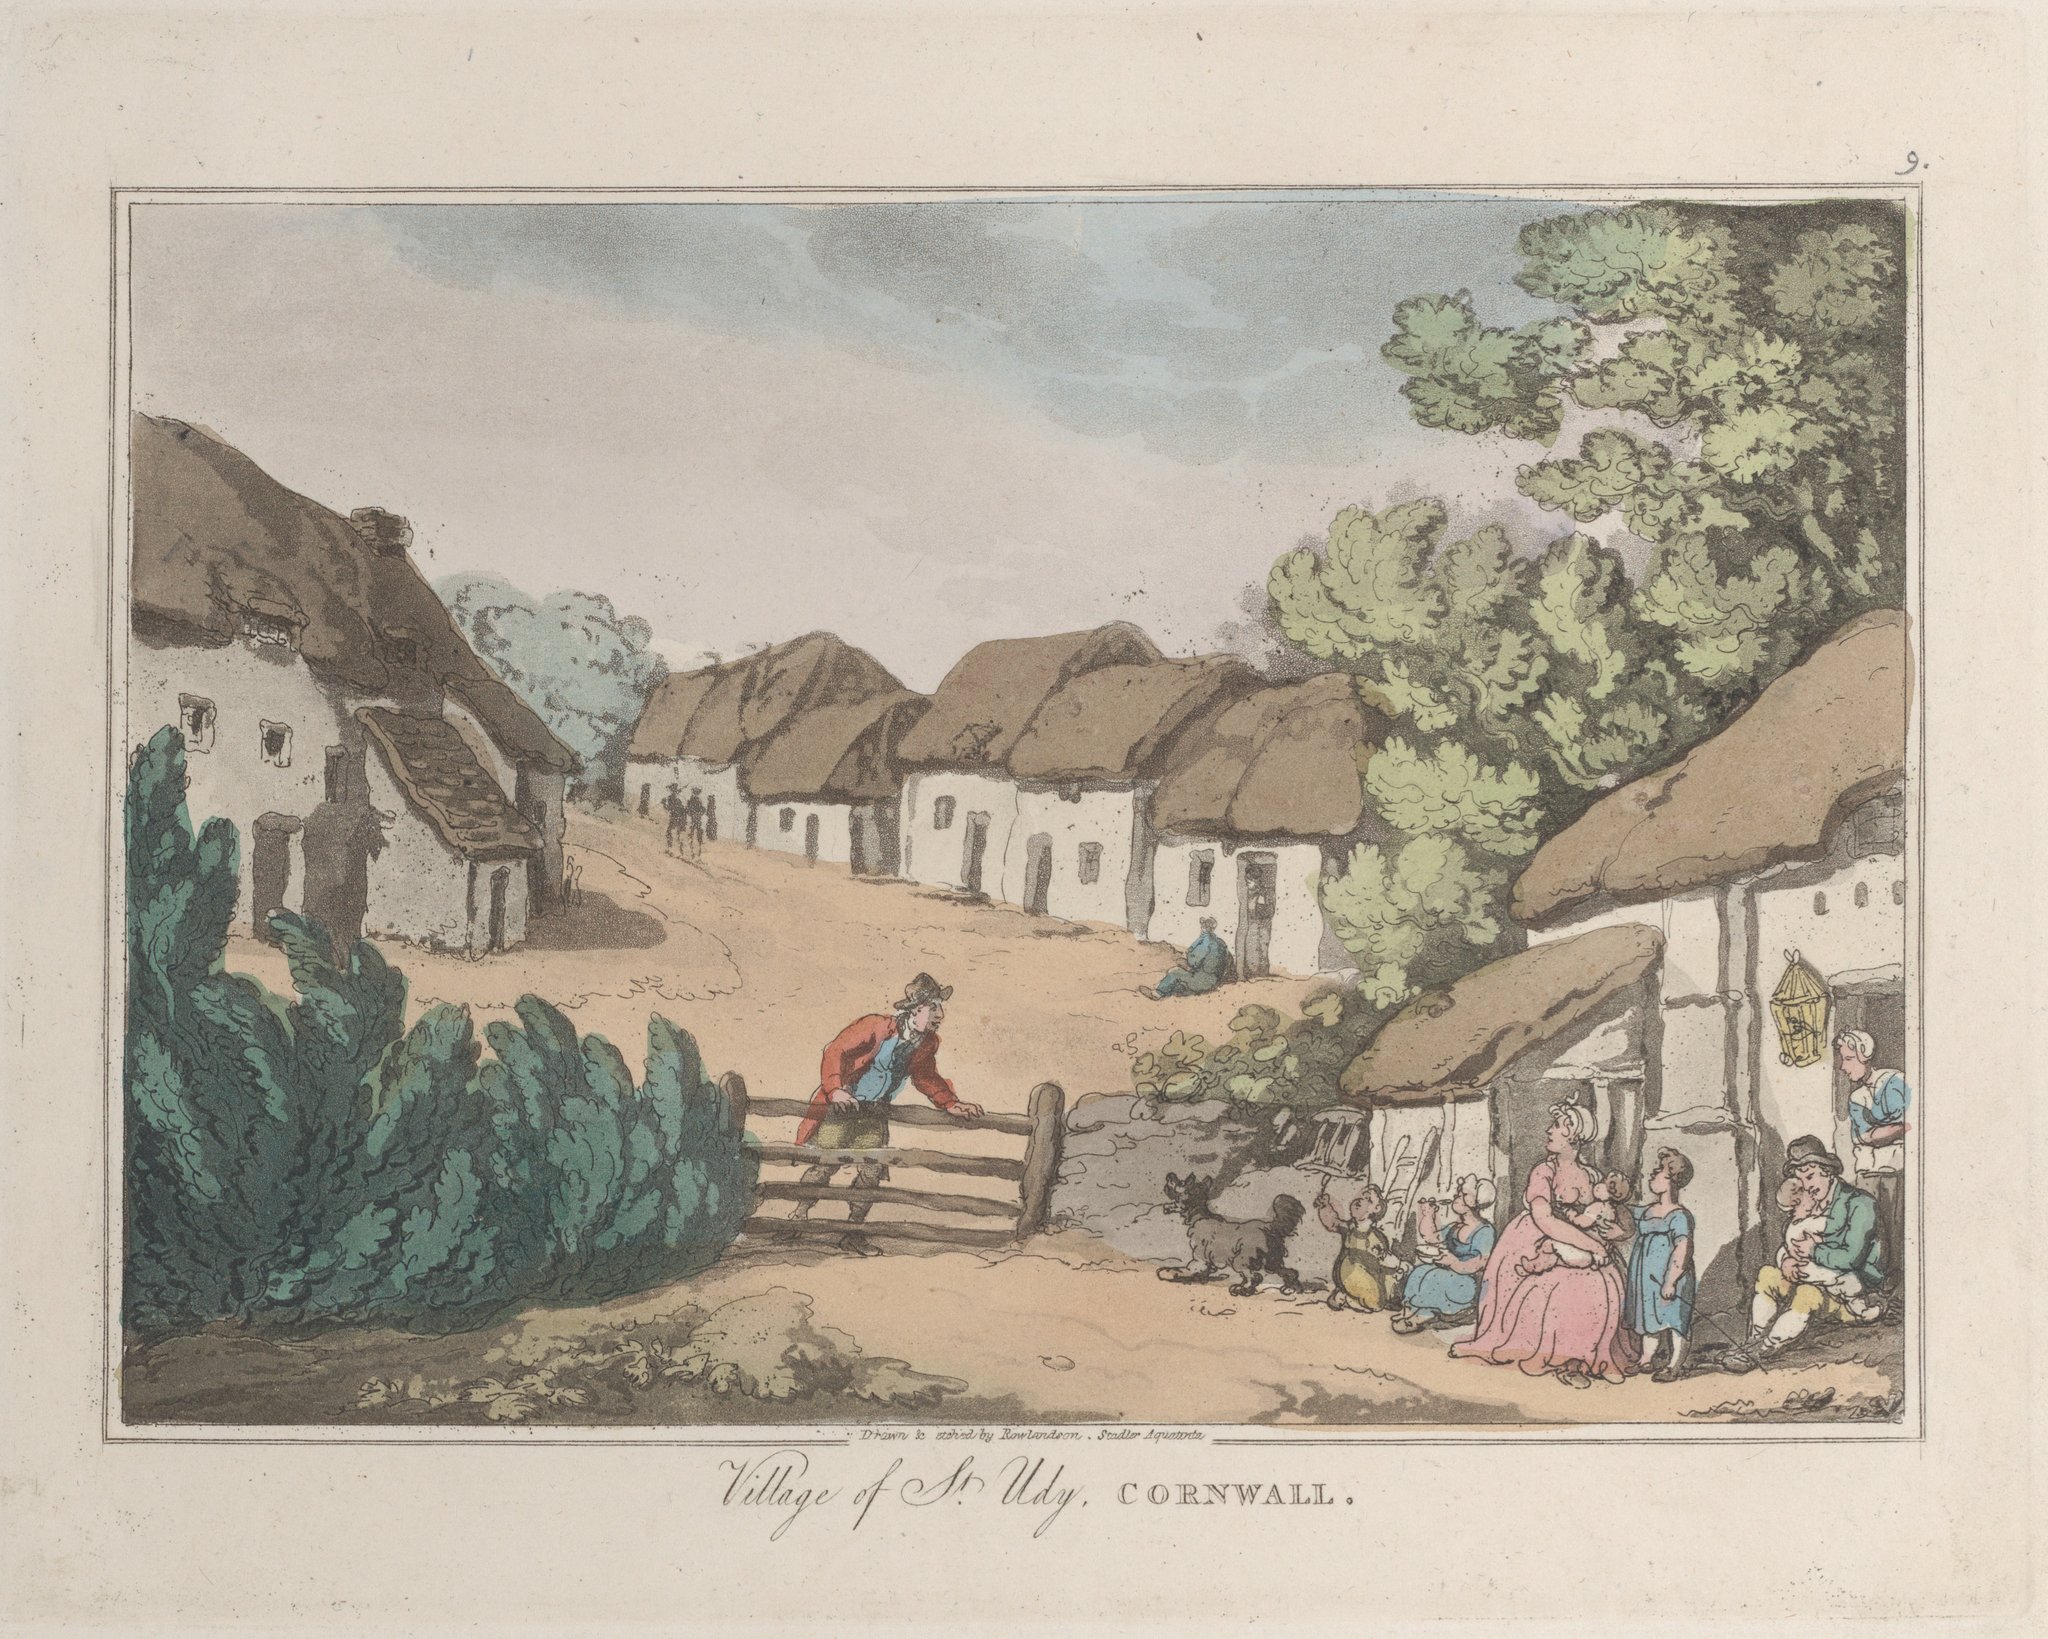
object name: print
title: Village of St. Udy, Cornwall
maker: thomas rowlandson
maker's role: artist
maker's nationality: british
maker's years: 1757-1827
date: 1822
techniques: aquatint, etching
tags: villages,children,men,women,dogs